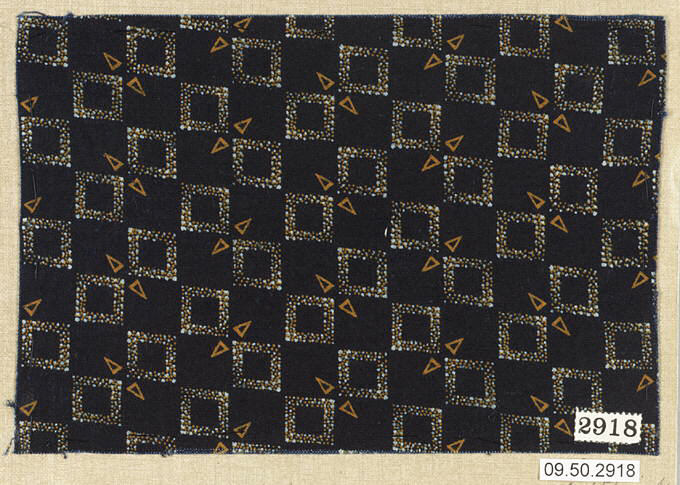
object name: piece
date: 1801-1900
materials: cotton